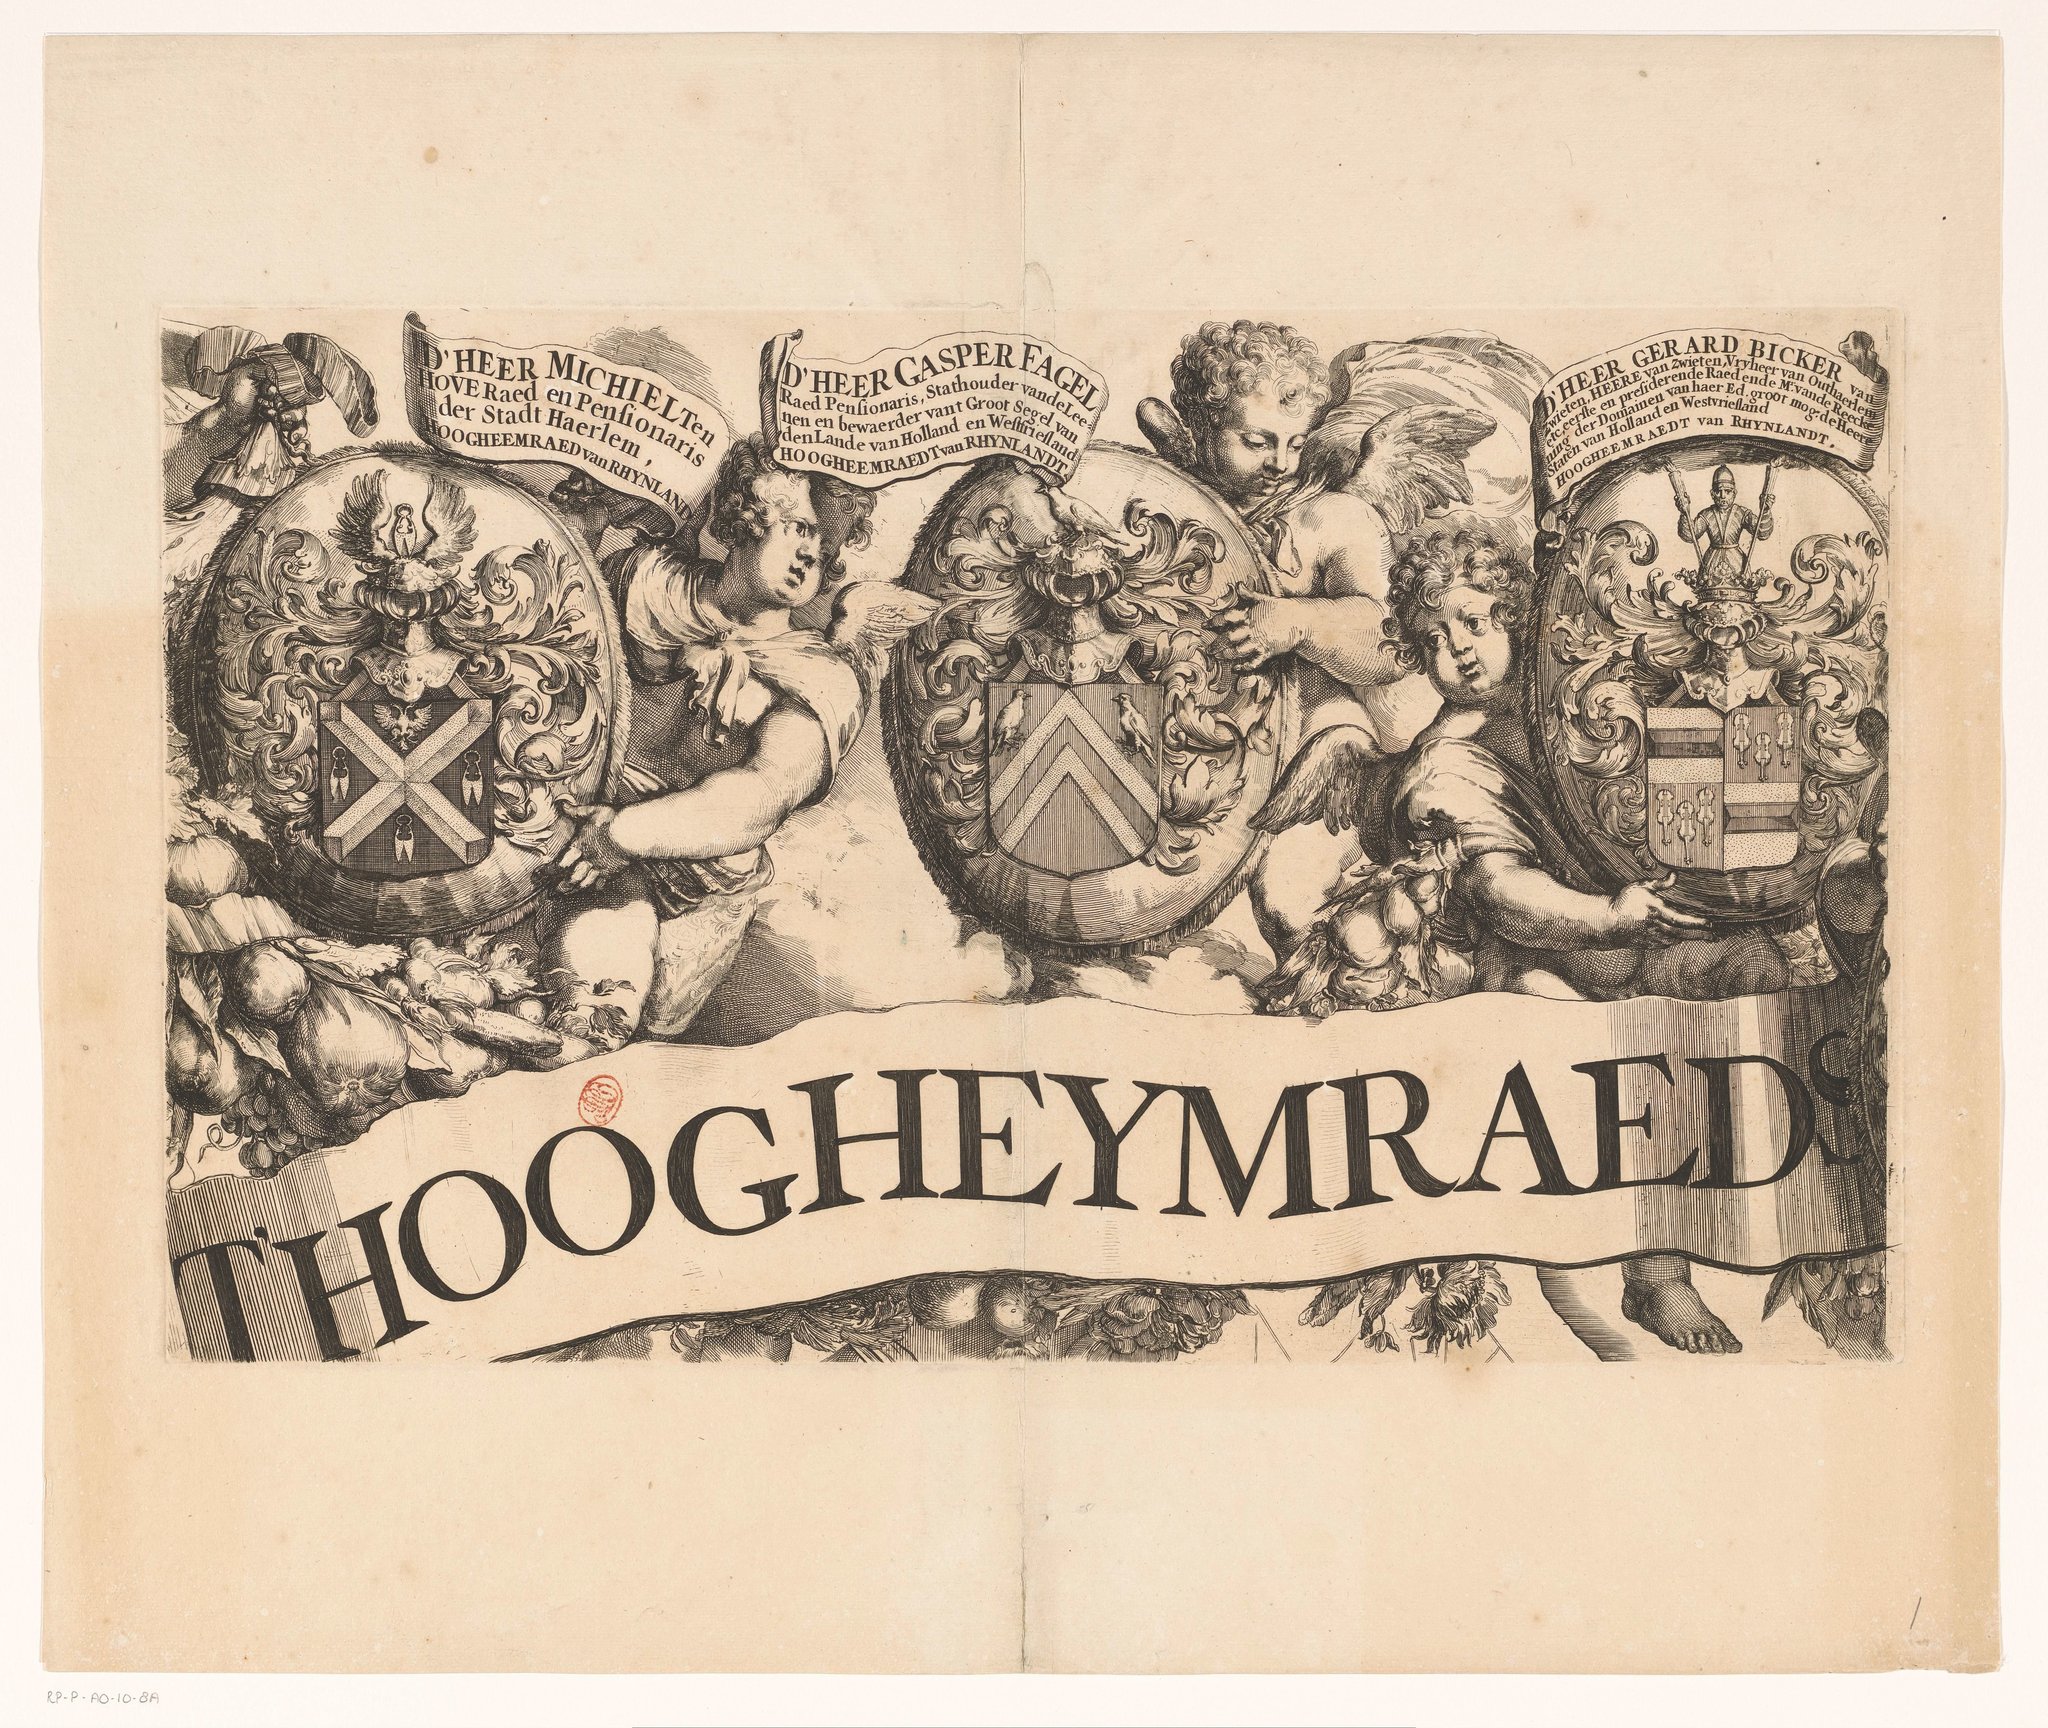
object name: print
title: T' Hoogheymraedschap van Rhynland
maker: romeyn de hooghe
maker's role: draughtsman, goldsmith, painter, print maker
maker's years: 1645-1708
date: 1687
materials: paper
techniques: engraving, etching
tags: armorial bearing, heraldry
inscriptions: collector's mark: Lugt 195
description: Deze prent behoort tot de tweede druk (1687) van 'T' Hoogheymraedschap van Rhynland', een wandkaart van het Hoogheemraadschap van Rijnland bestaande uit een kaart van het gebied en een sierrand. Van deze kaart zijn voor zover na te gaan drie verschillende drukken bekend, uit respectievelijk 1647, 1687 en 1746. Het kaartdeel is gedrukt van twaalf platen die voor elke druk zijn aangepast. Het vijfde blad van het kaartdeel (RP-P-AO-10-8H) is in of na 1766 nog een keer bijgewerkt en los uitgegeven. Hierdoor zijn van het vijfde blad vier staten bekend en van de overige bladen drie. Zie documentatie voor meer informatie. Bij de eerste en tweede druk hoort een sierrand met daarop de titel, wapenschilden en octrooiverleningen. Delen van de zijkant van de rand van de eerste druk zijn voor de tweede druk herbruikt, terwijl andere delen van de zijkanten en de hele bovenkant nieuw zijn gemaakt door Romeyn de Hooghe. De derde druk heeft slechts een nieuw gemaakte titelstrook langs de bovenkant.